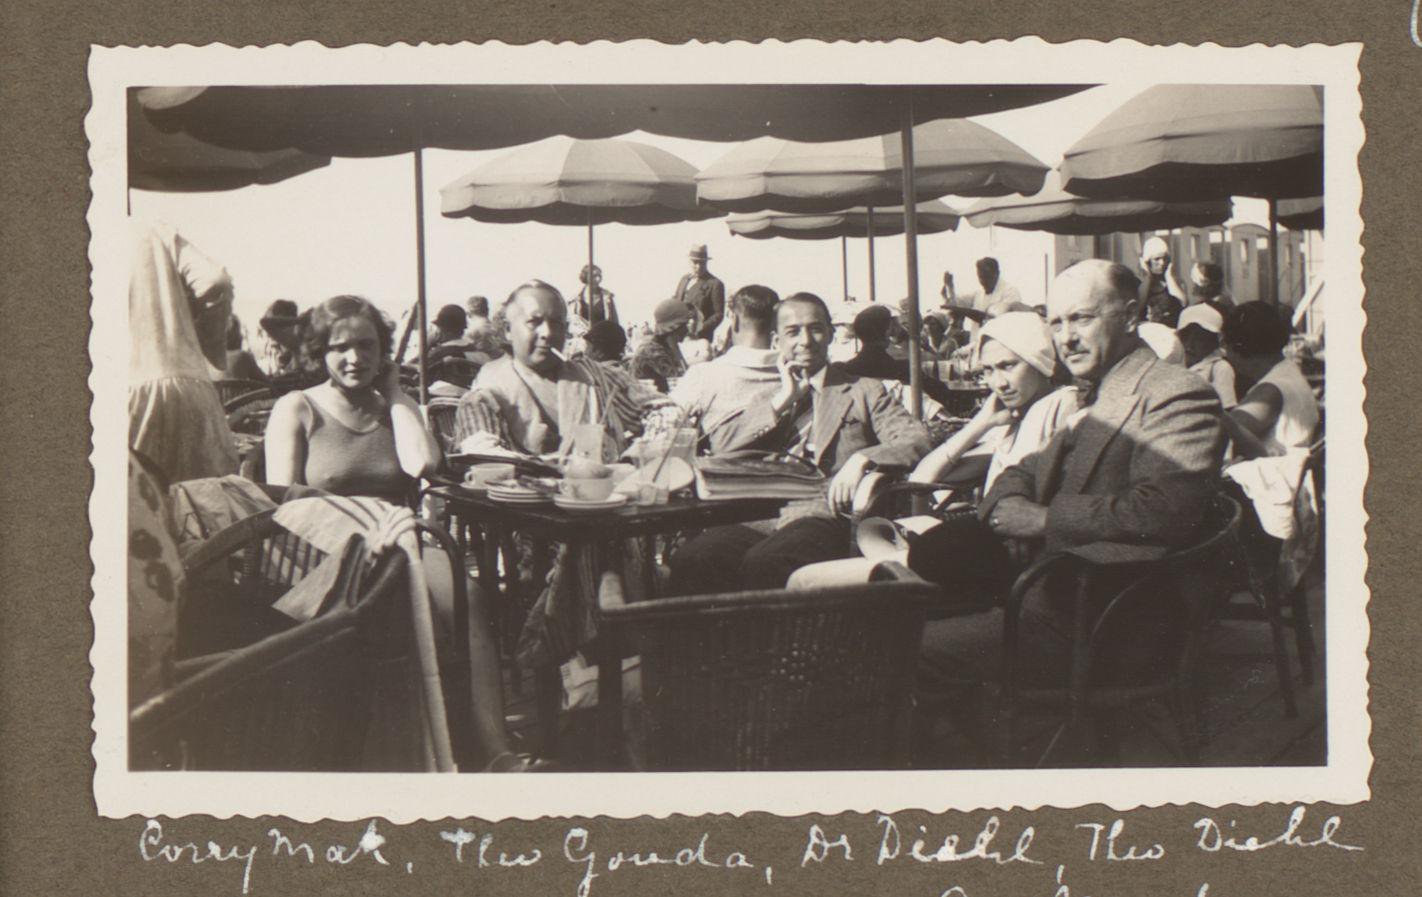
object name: album leaf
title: Gezelschap op een terras in Scheveningen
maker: Anonymous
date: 1908-1932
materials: paper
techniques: gelatin silver print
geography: scheveningen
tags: pavement, terrace in front of inn or restaurant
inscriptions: inscription: ‘Corry Mak, Theo Gouda, Dr Diehl, Theo Diehl/ Dr. Mak’